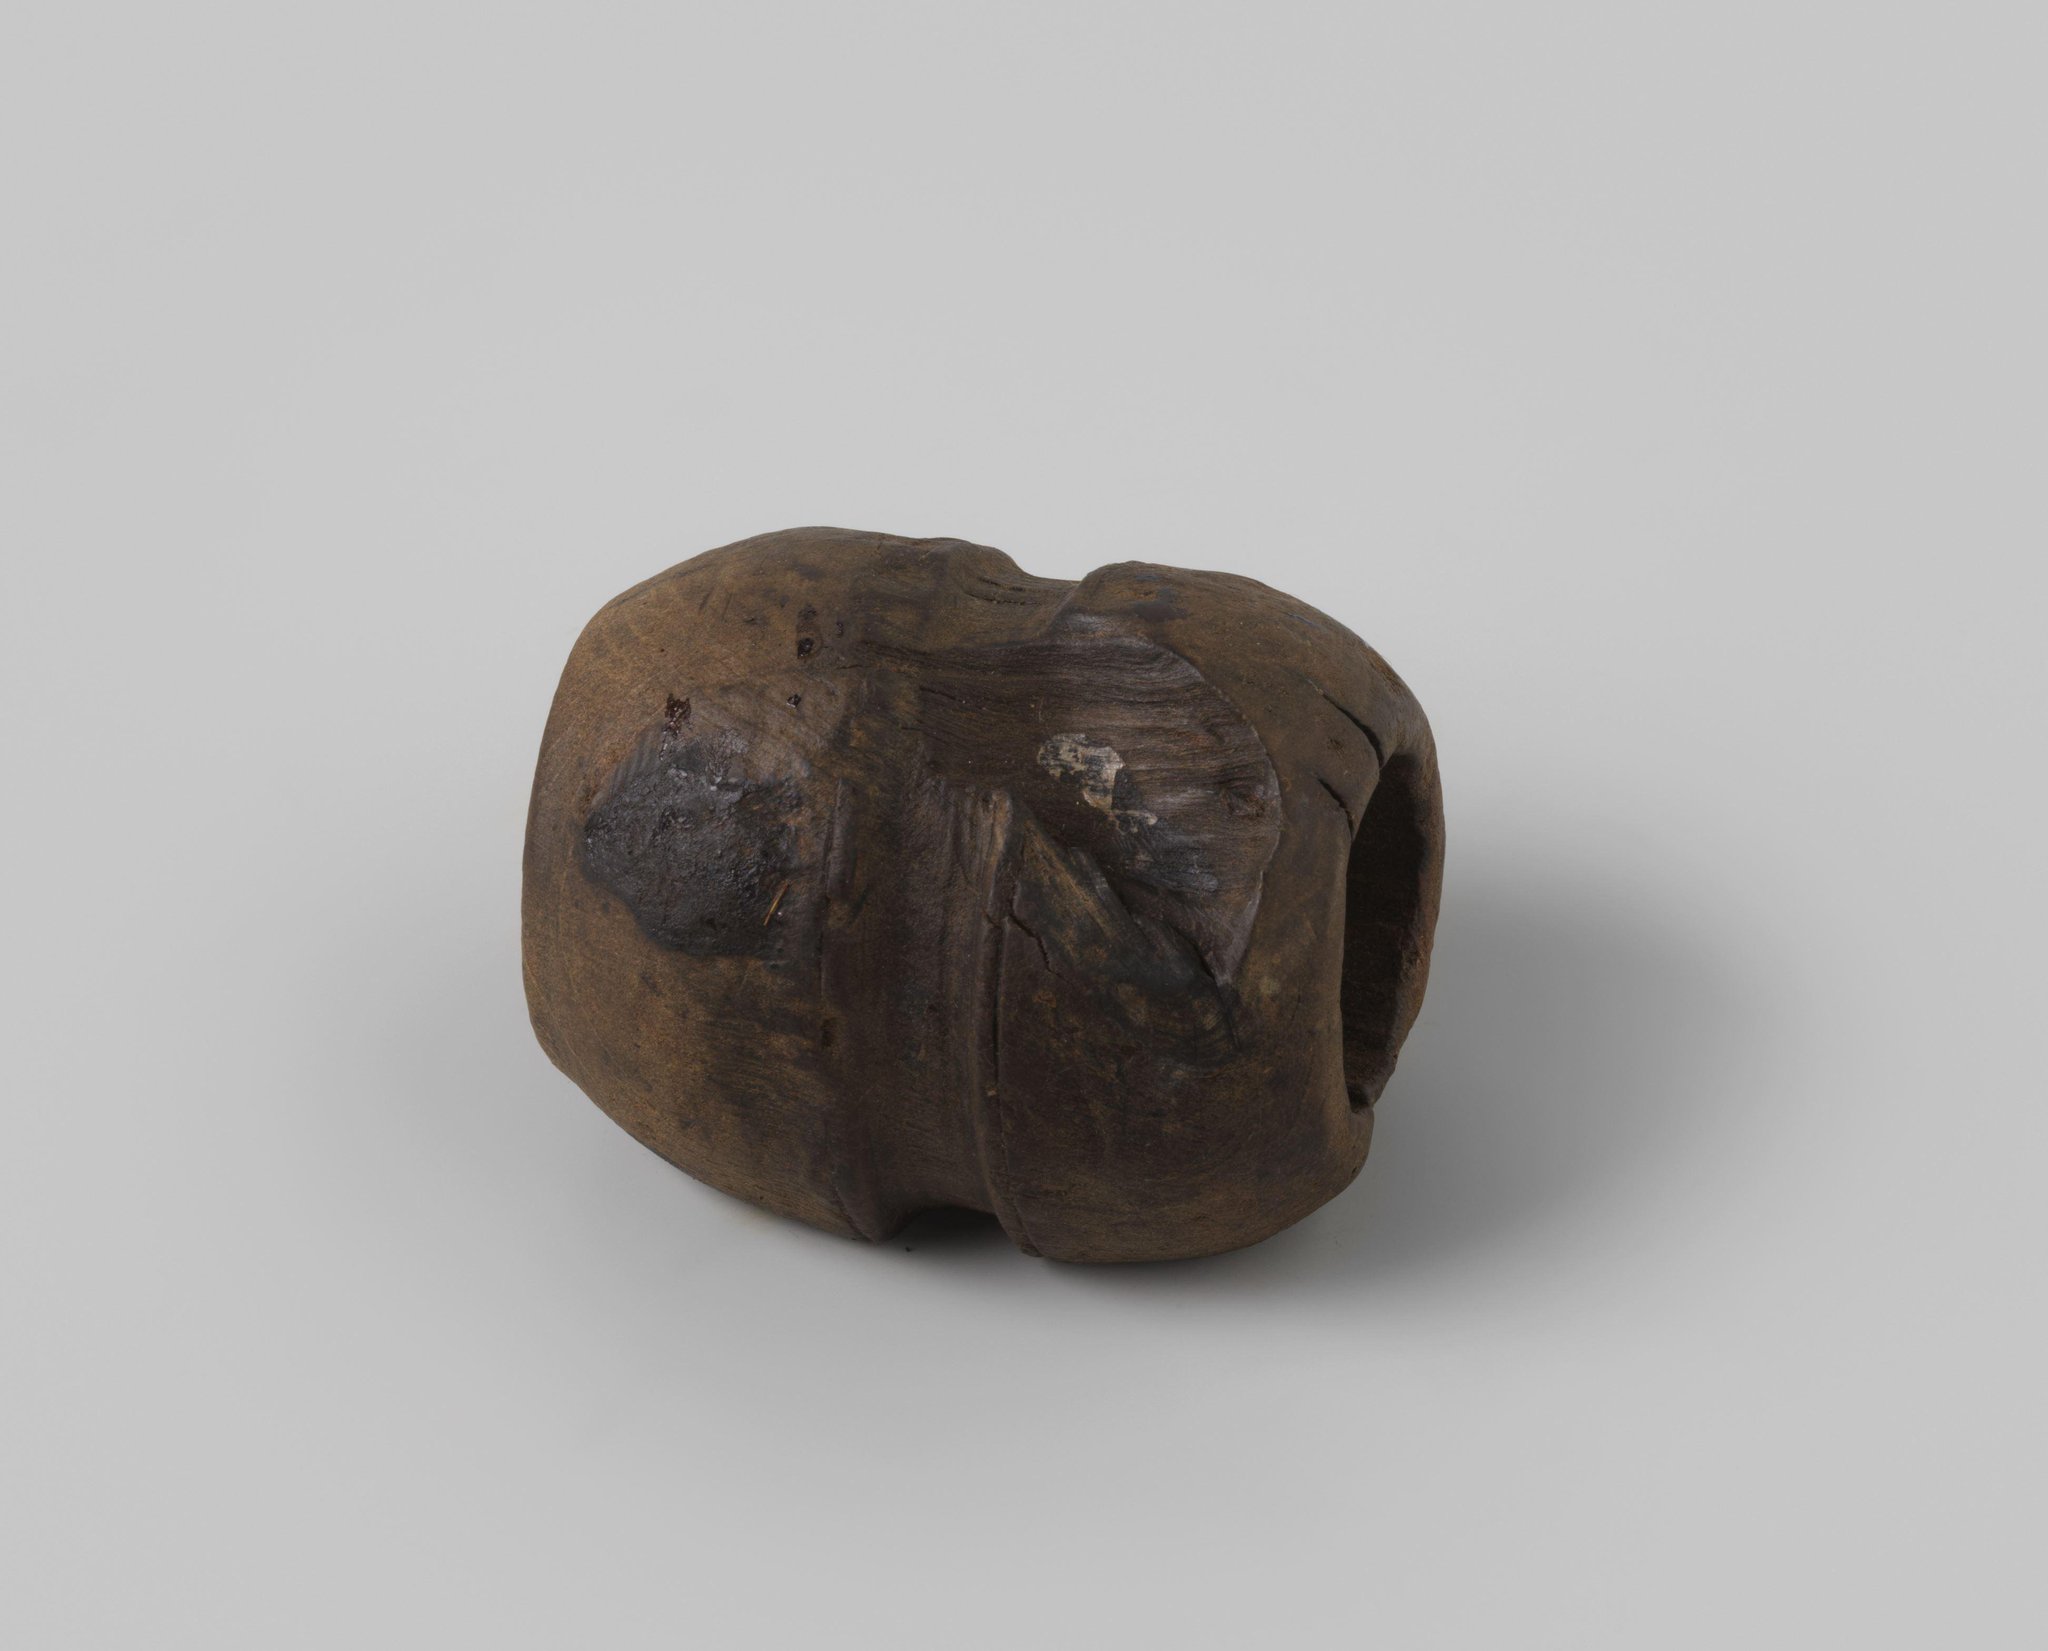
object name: klootje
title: Wantklootje uit het wrak van de Oost-Indiëvaarder Hollandia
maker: Anonymous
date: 1700-1743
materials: wood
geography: netherlands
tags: verenigde oostindische compagnie, hollandia (schip), annet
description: Bead, shroudtruck; cylindrical, flat tapered end, hollow circular core, horizontal notch along centre, one broad vertical notch, semicircular in section.